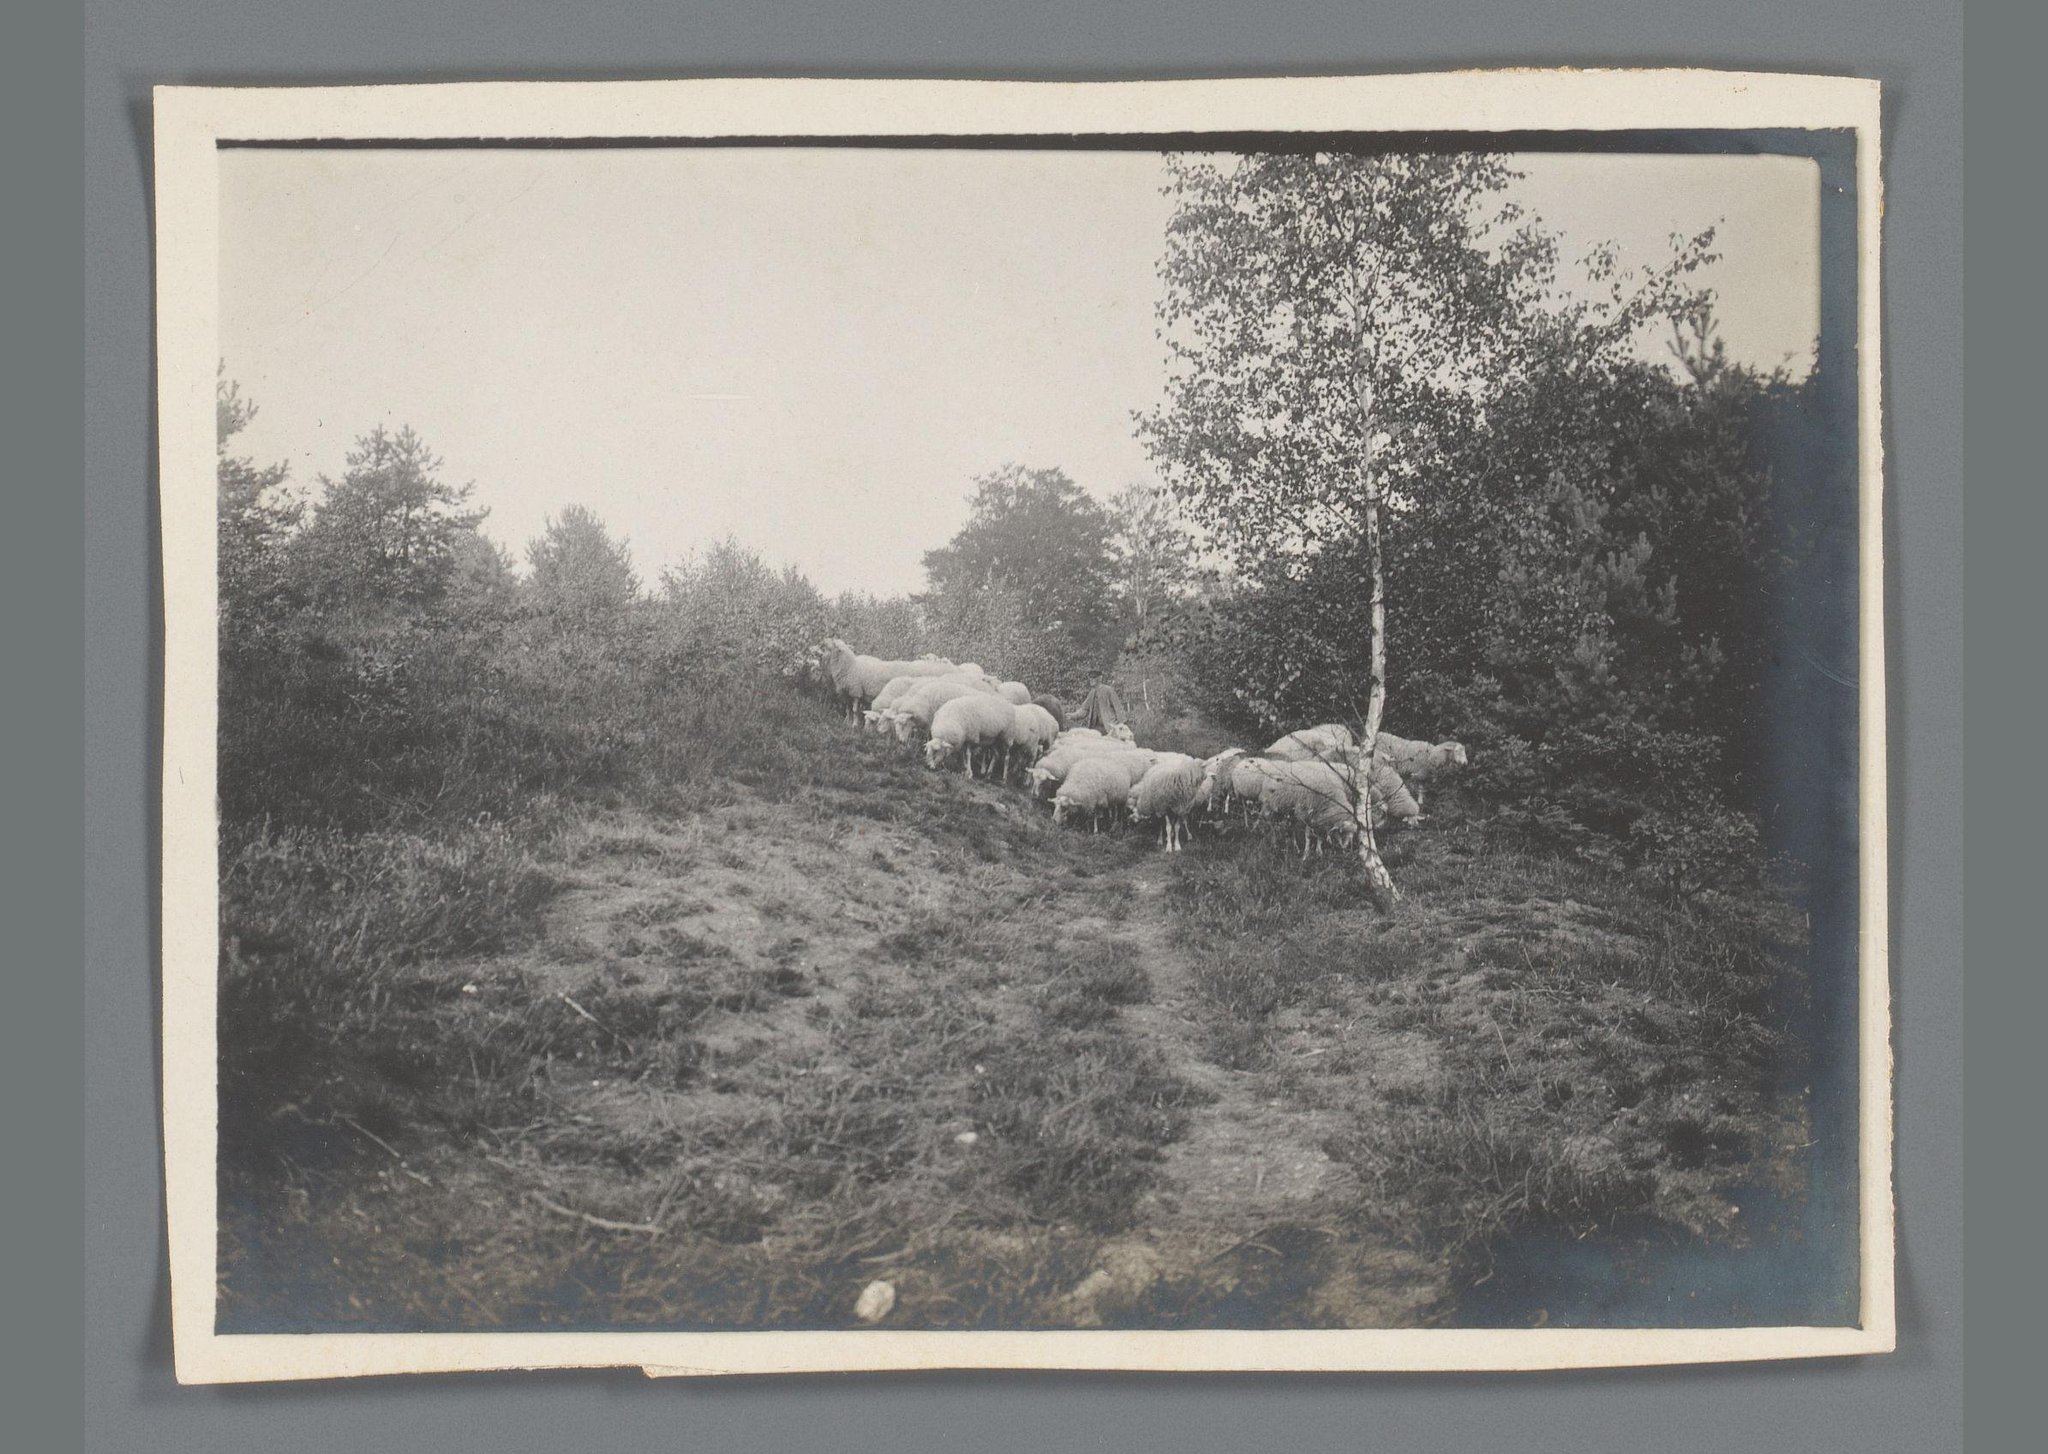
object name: photograph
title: Boer met schapen in landschap in Limburg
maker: willem de jong (fotograaf)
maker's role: arts, fotograaf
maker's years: 1864-1918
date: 1895-1918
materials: paper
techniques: gelatin silver print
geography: limburg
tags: sheep, shearing (sheep)